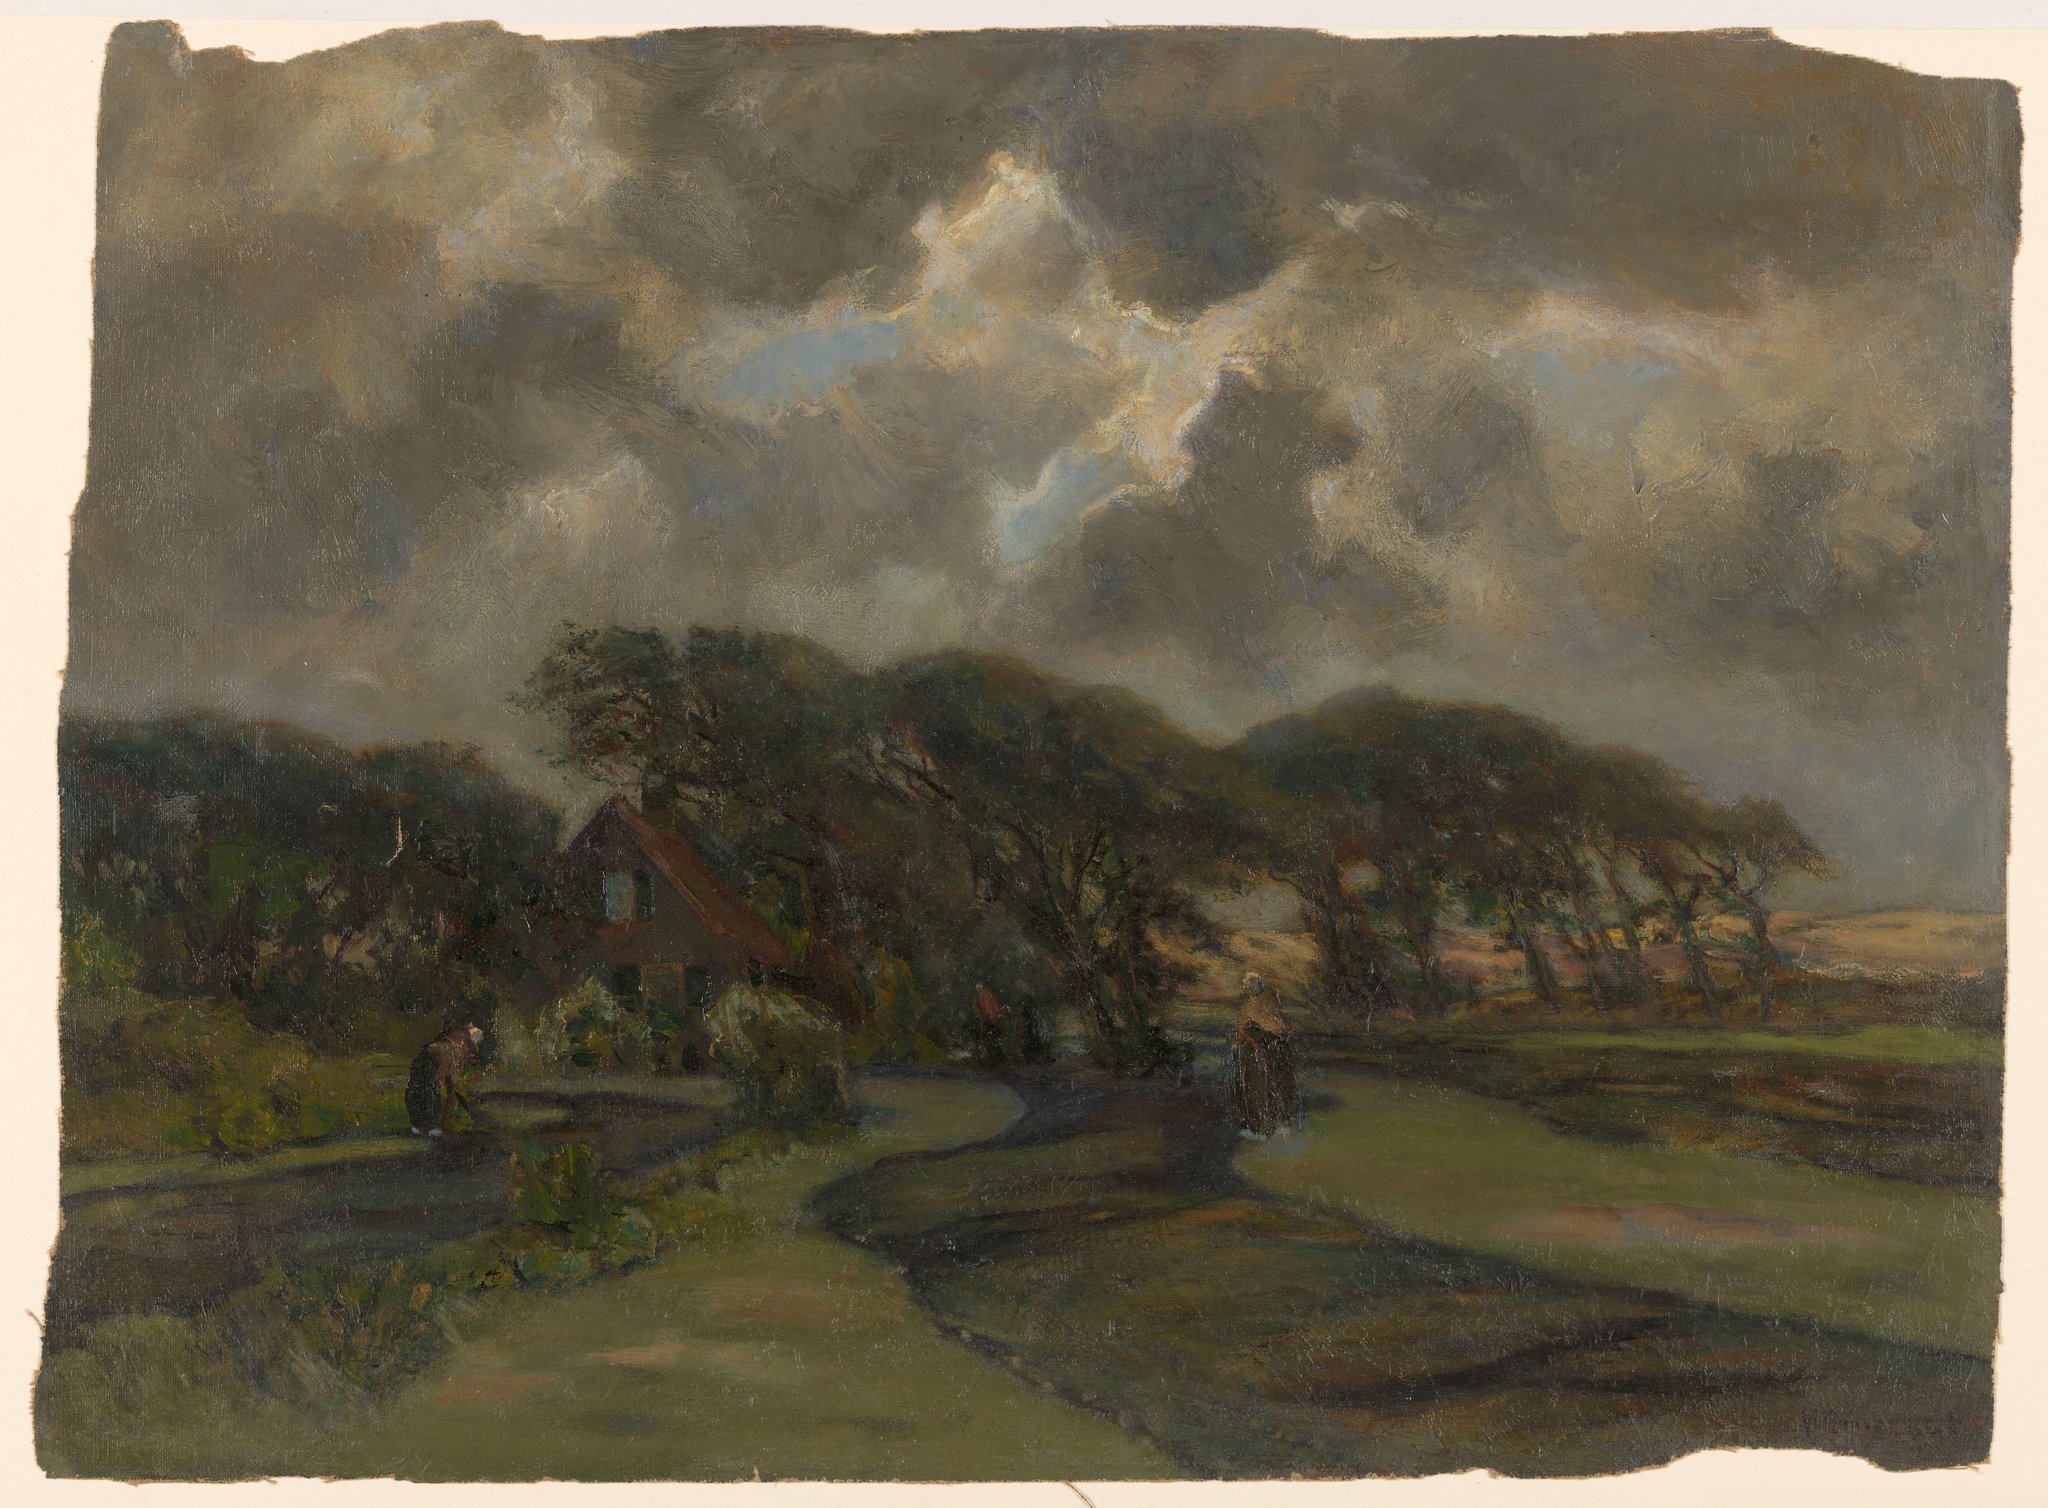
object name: painting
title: Huisje bij boomrand en vrouwen met visnetten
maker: frans smissaert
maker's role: draughtsman, print maker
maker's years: 1862-1944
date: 1872-1944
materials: linen, oil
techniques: brush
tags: dunes (sea not visible); in the dunes, farm or solitary house in landscape, mending of fishing nets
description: Huisje bij boomrand, waar vrouwen bezig zijn met de visnetten, op de achtergrond een duinenrij tegen een donkere wolkenlucht.